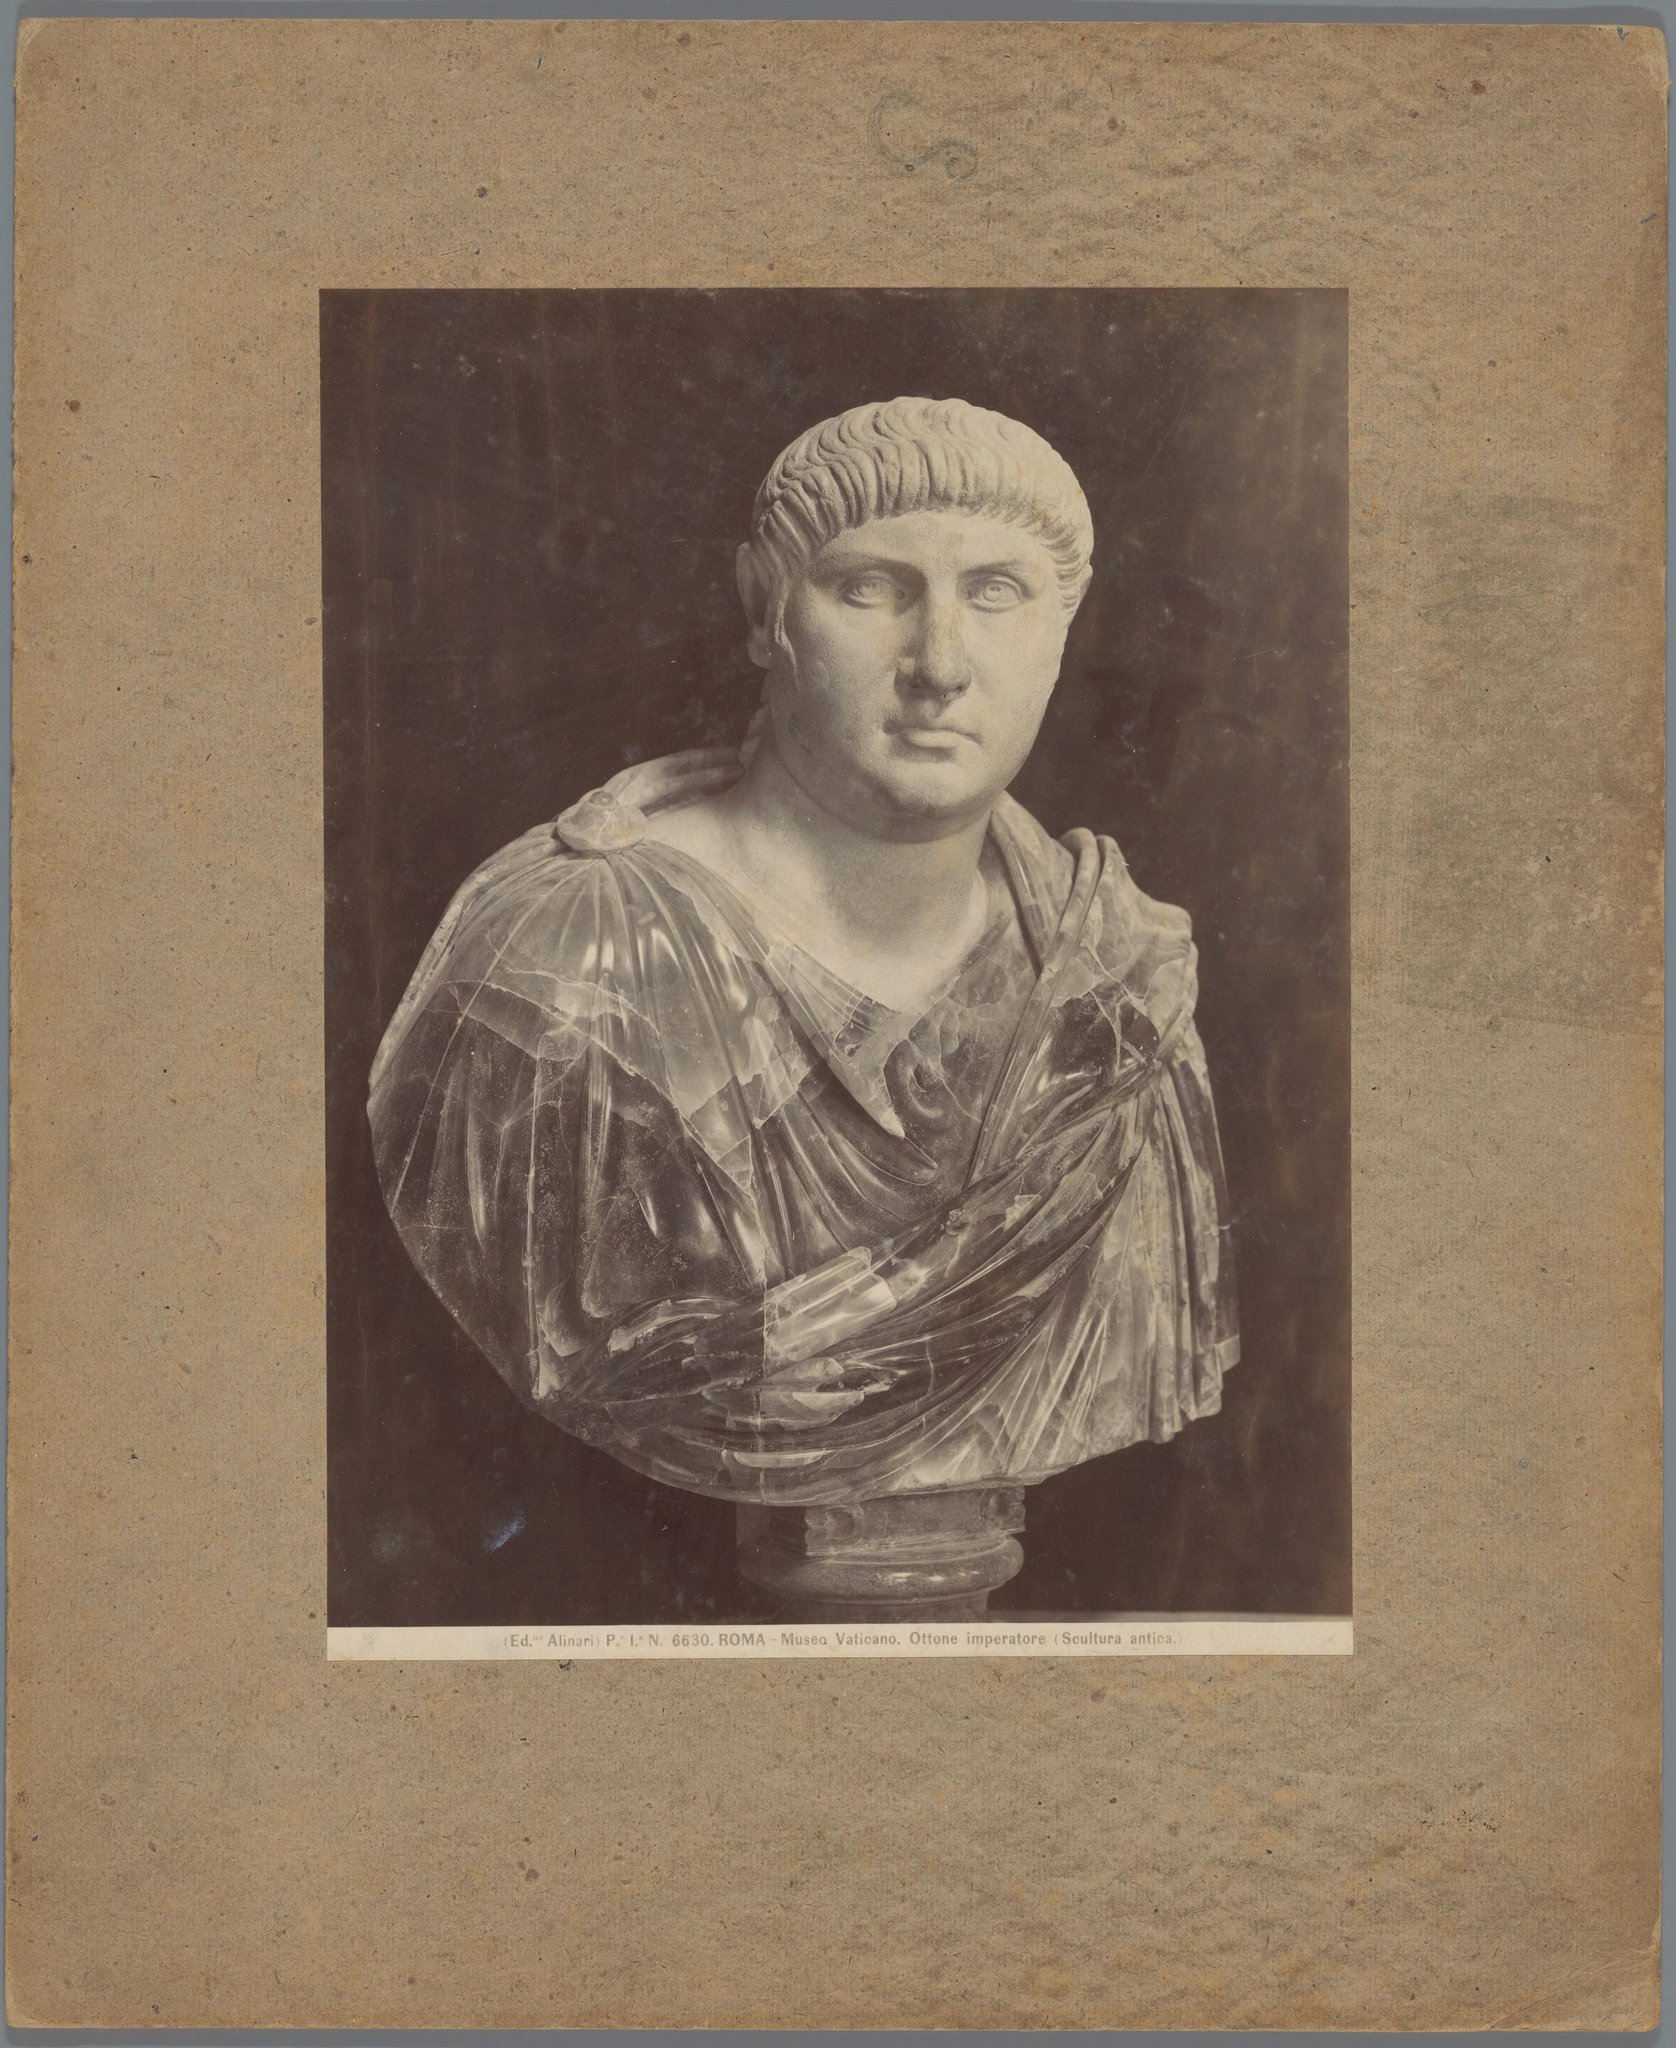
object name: photograph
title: ROMA- Museo Vaticano. Ottone imperatore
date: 1875-1900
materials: cardboard, photographic support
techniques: albumen print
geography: vatican museums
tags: emperor, sculpture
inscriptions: number: ‘P.e I.a N.o 6630.’, collector's mark: Lugt 3937